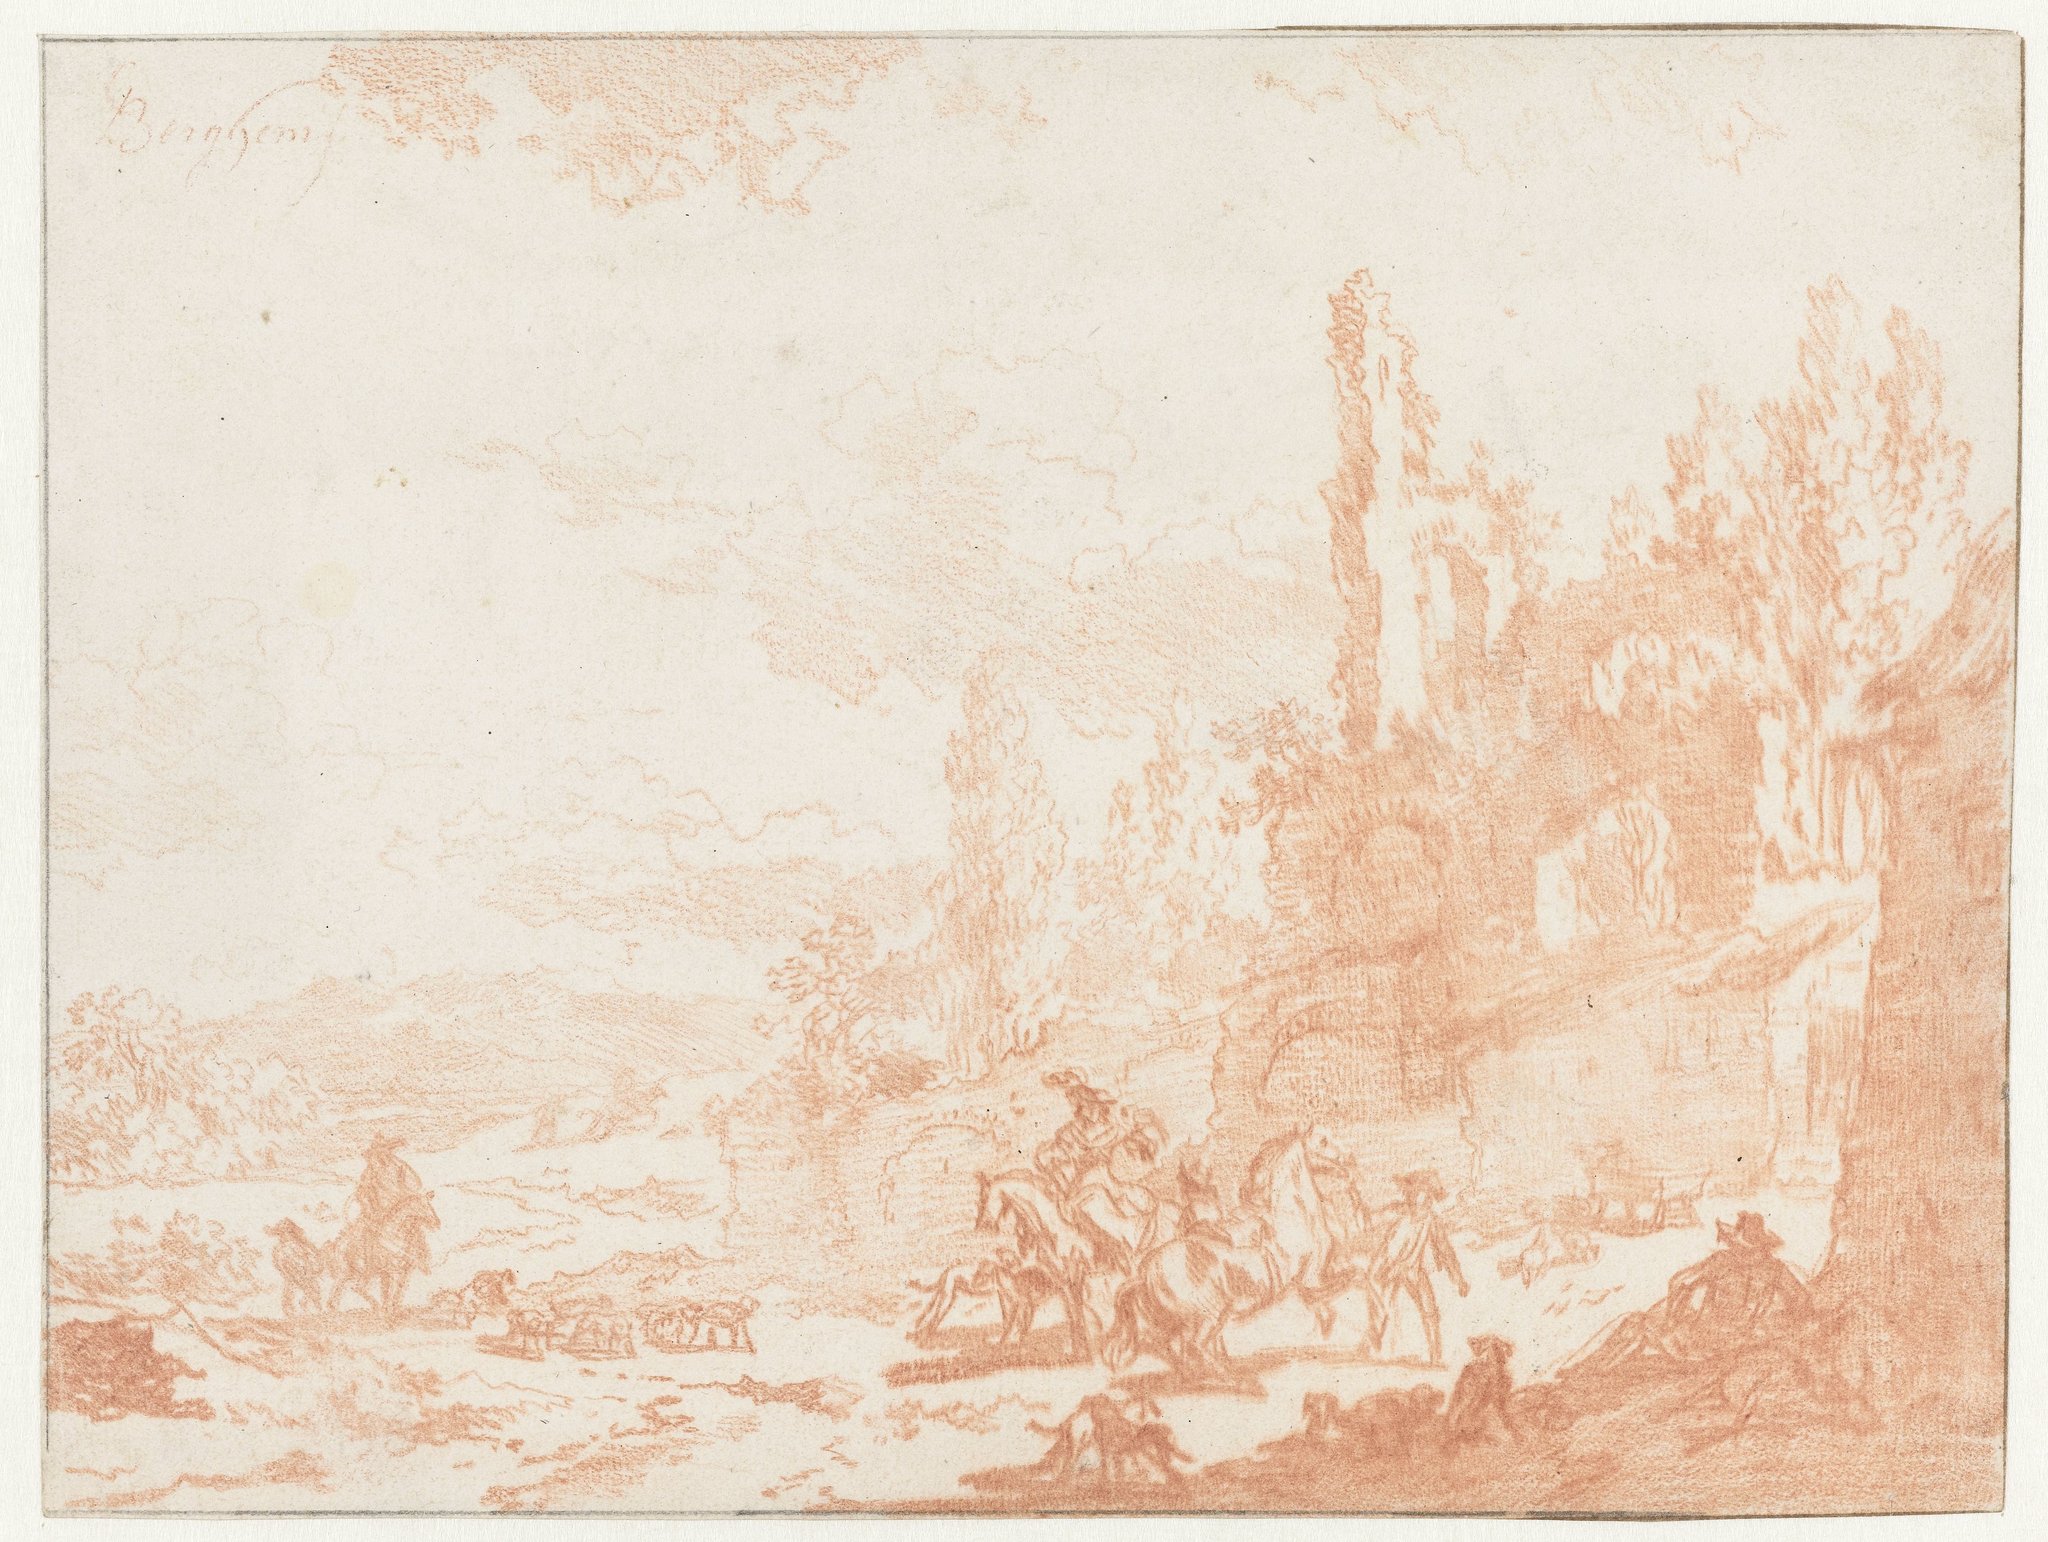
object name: drawing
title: Italianiserend landschap met mannen, paarden en honden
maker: nicolaes pietersz berchem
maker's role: draughtsman, print maker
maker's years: 1620-1683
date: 1630-1683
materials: chalk, paper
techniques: printmaking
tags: riding a horse, ass, or mule; rider, horseman, hunting, chase, landscape with ruins (+ city(-scape) with figures, staffage)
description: Landschap met mannen, paarden en honden; rechts een ruïne.